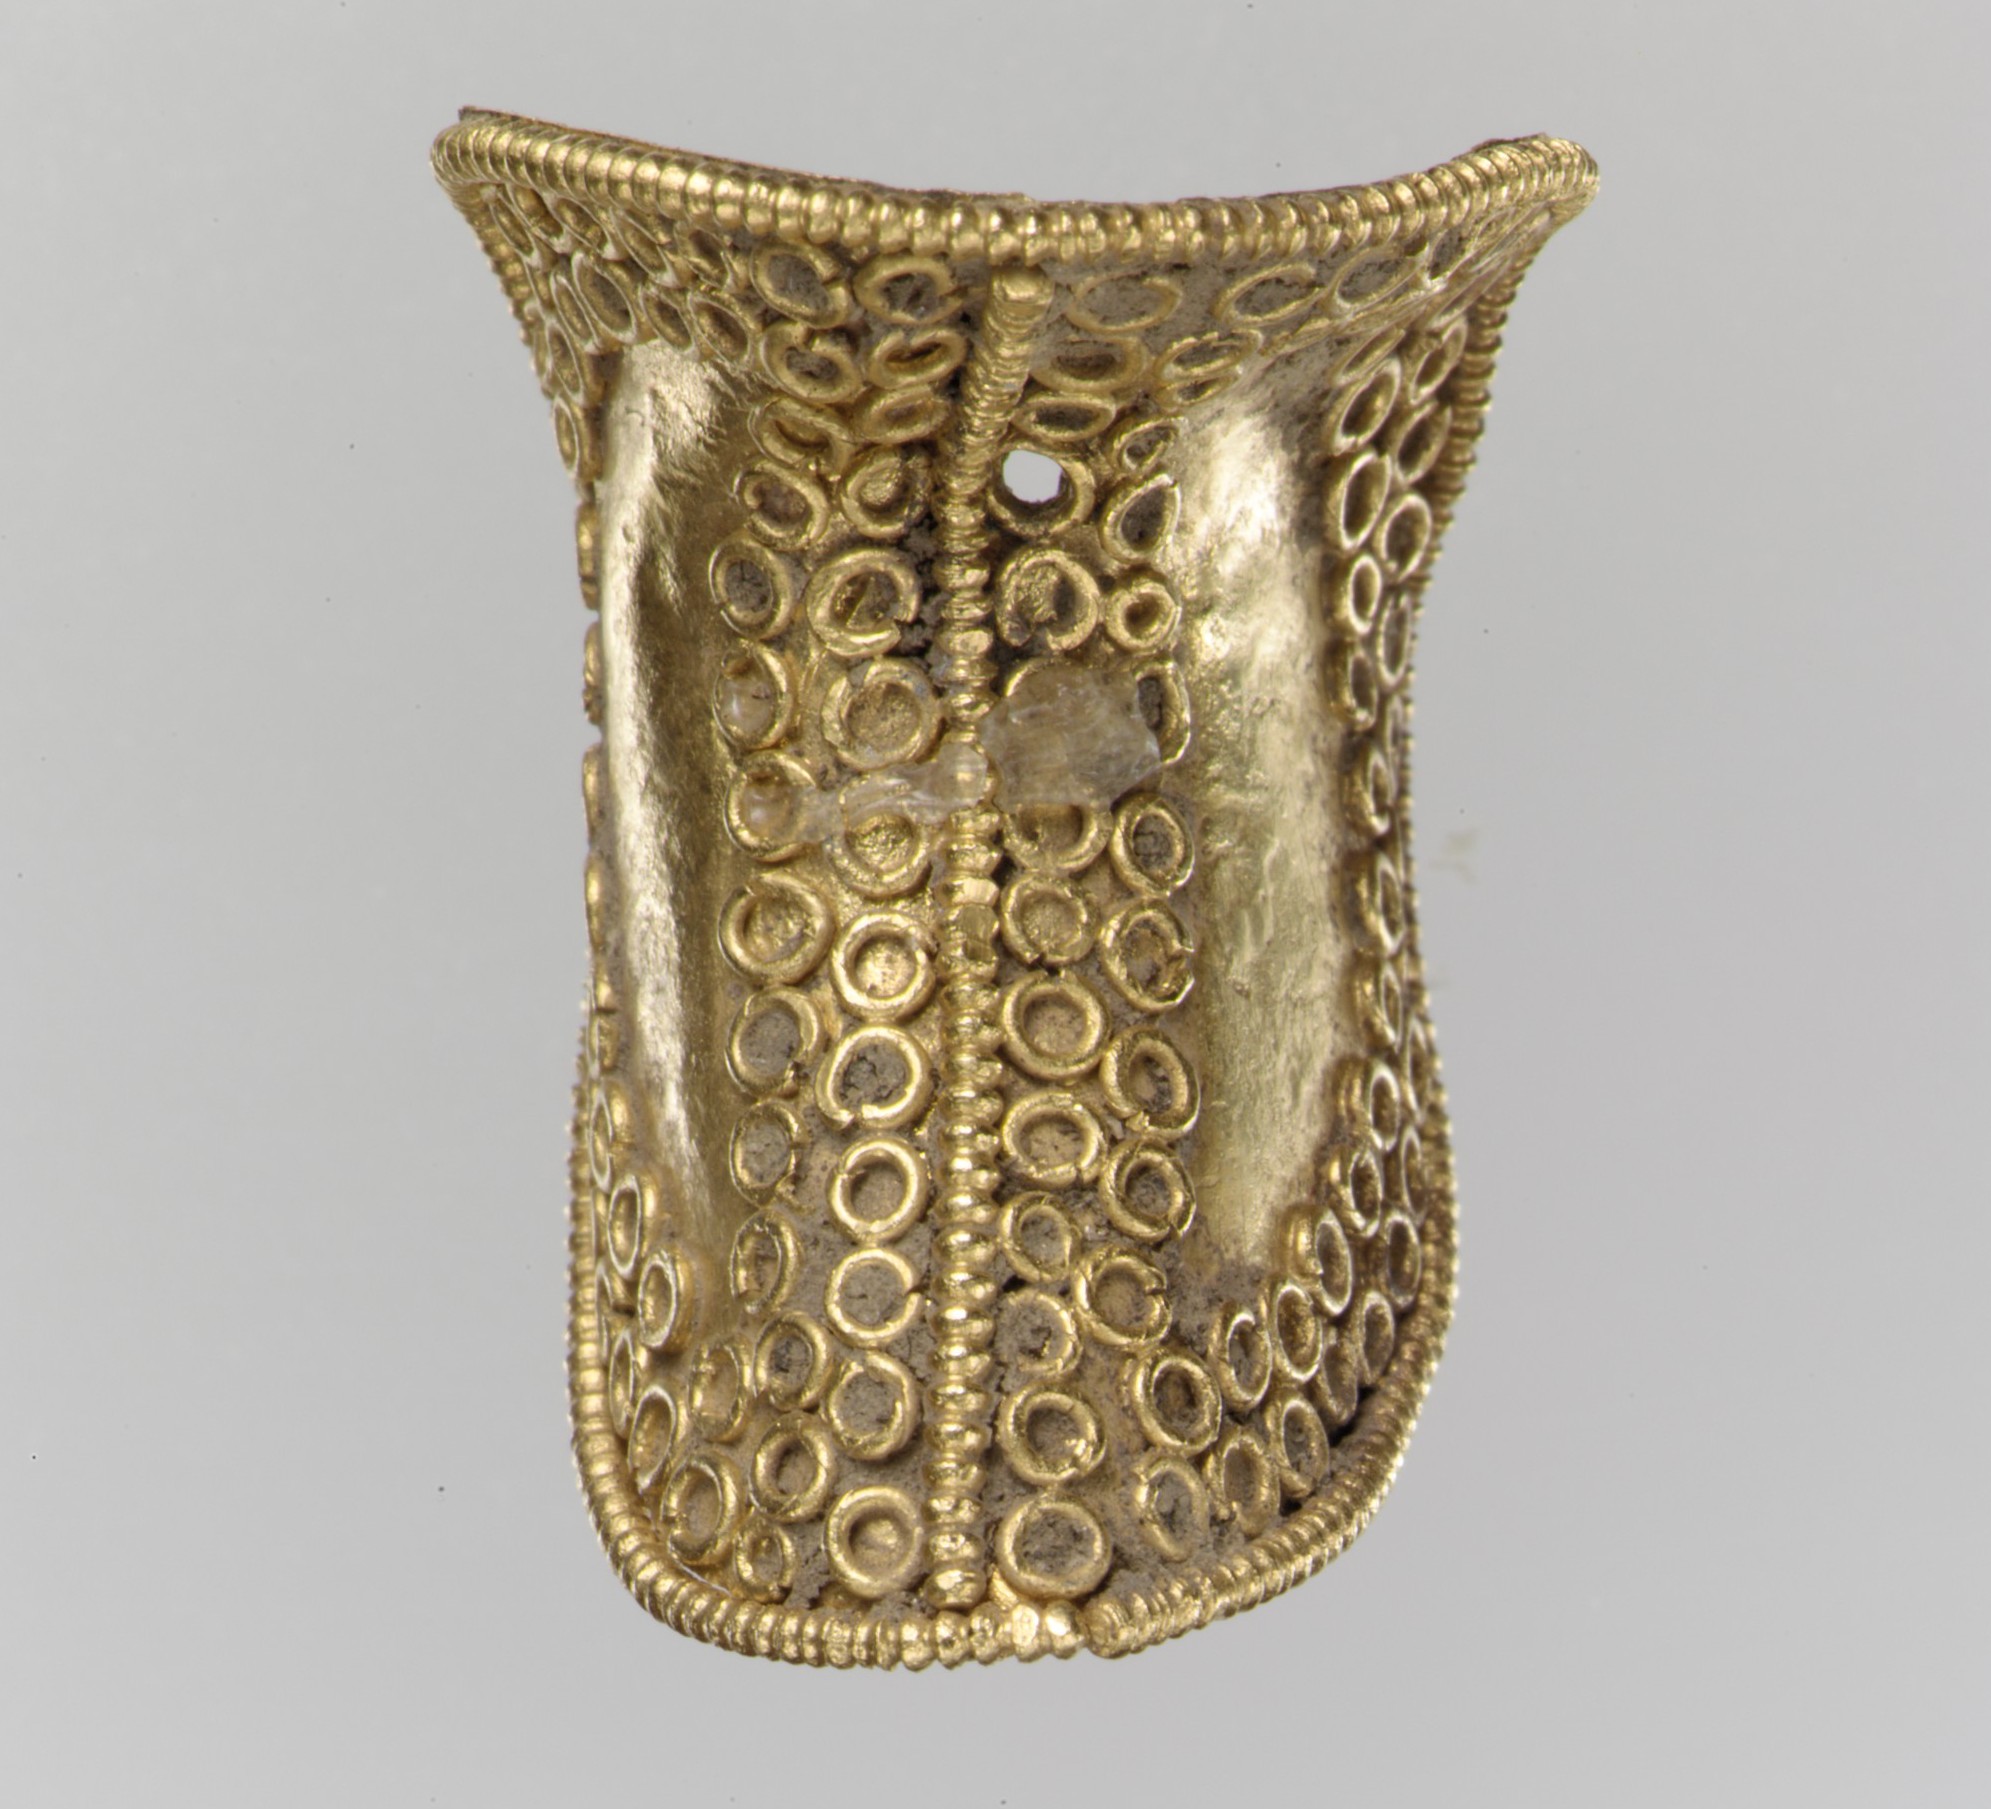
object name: sword grip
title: Gold Ornament from a Sword Grip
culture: langobardic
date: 600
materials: gold